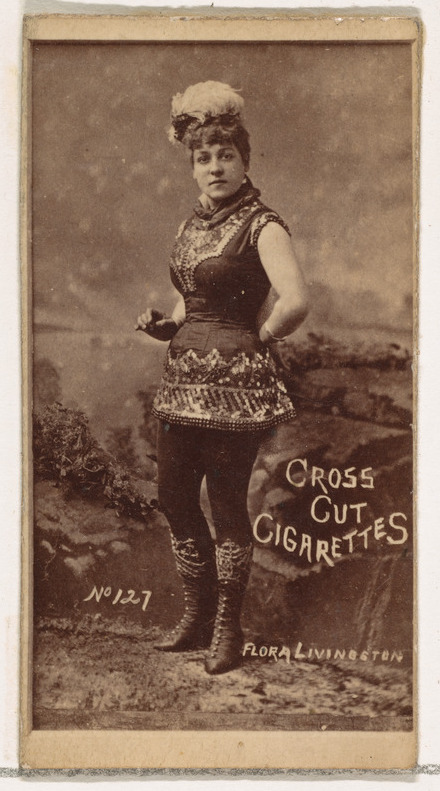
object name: print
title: Card Number 127, Flora Livingston, from the Actors and Actresses series (N145-1) issued by Duke Sons & Co. to promote Cross Cut Cigarettes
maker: w. duke, sons & co.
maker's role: publisher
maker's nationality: american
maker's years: 1870-1920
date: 1880-1889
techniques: albumen silver print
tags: portraits,women,actresses